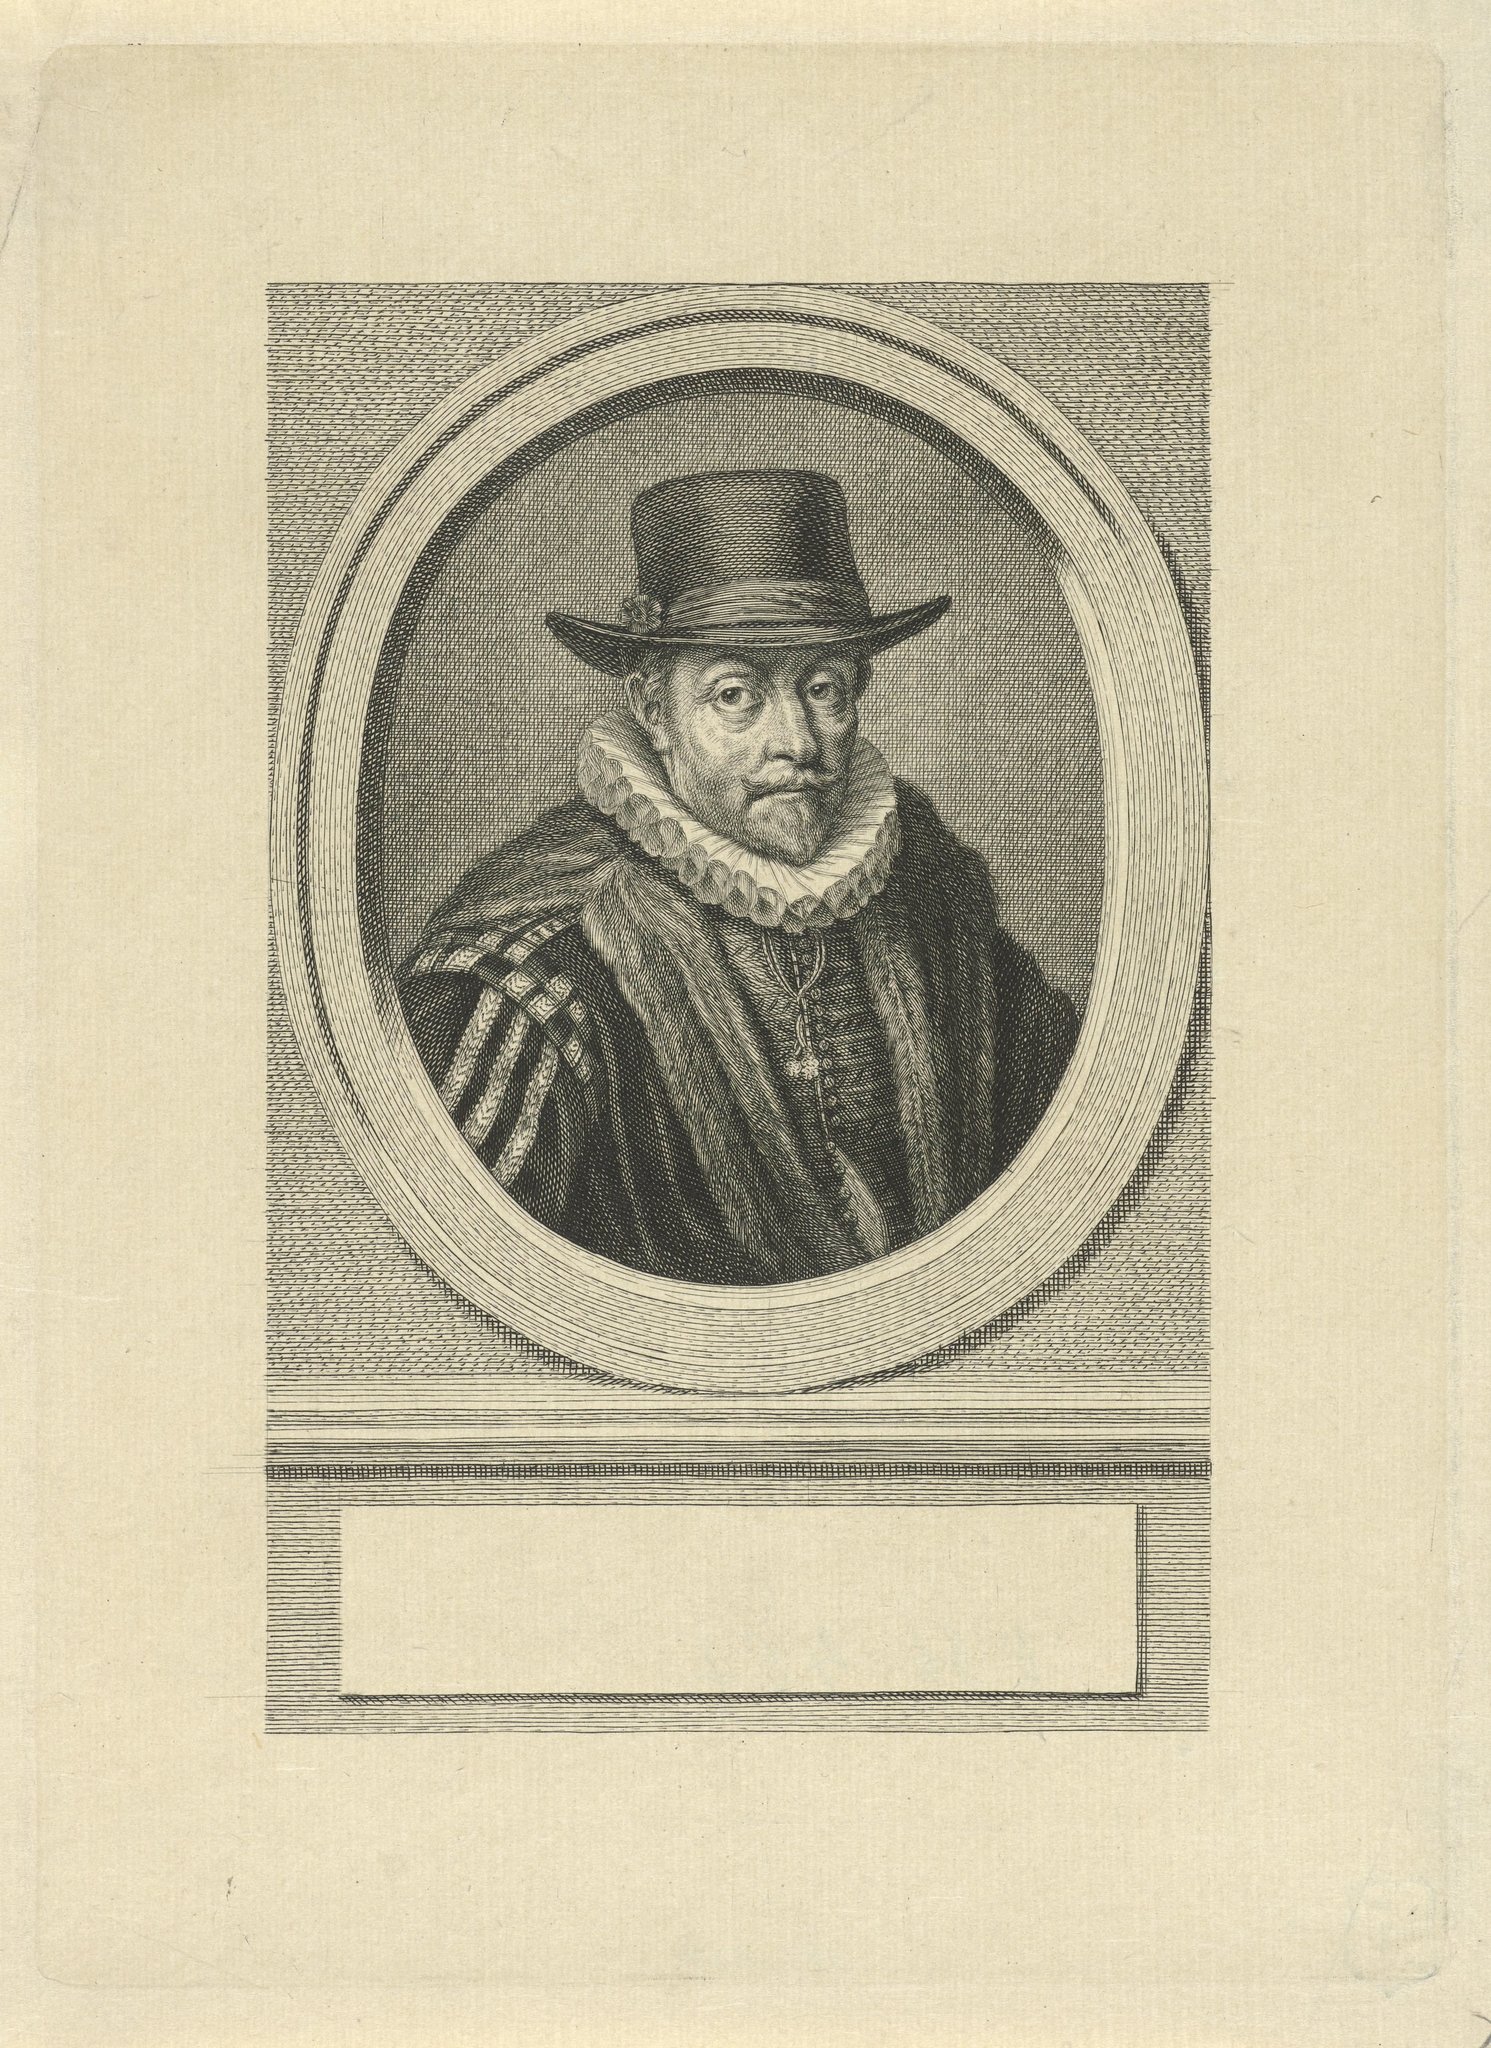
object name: print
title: Portret van Willem I, prins van Oranje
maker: jacob houbraken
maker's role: draughtsman, print maker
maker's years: 1698-1780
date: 1779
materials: paper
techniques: engraving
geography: amsterdam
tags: delft, william i (prince of orange)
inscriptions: collector's mark: Lugt 963, collector's mark: Lugt 2228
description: Portret naar rechts van Willem I, prins van Oranje, in een ovaal. Het portret rust op een plint waarop een leeg veld voor zijn naam.